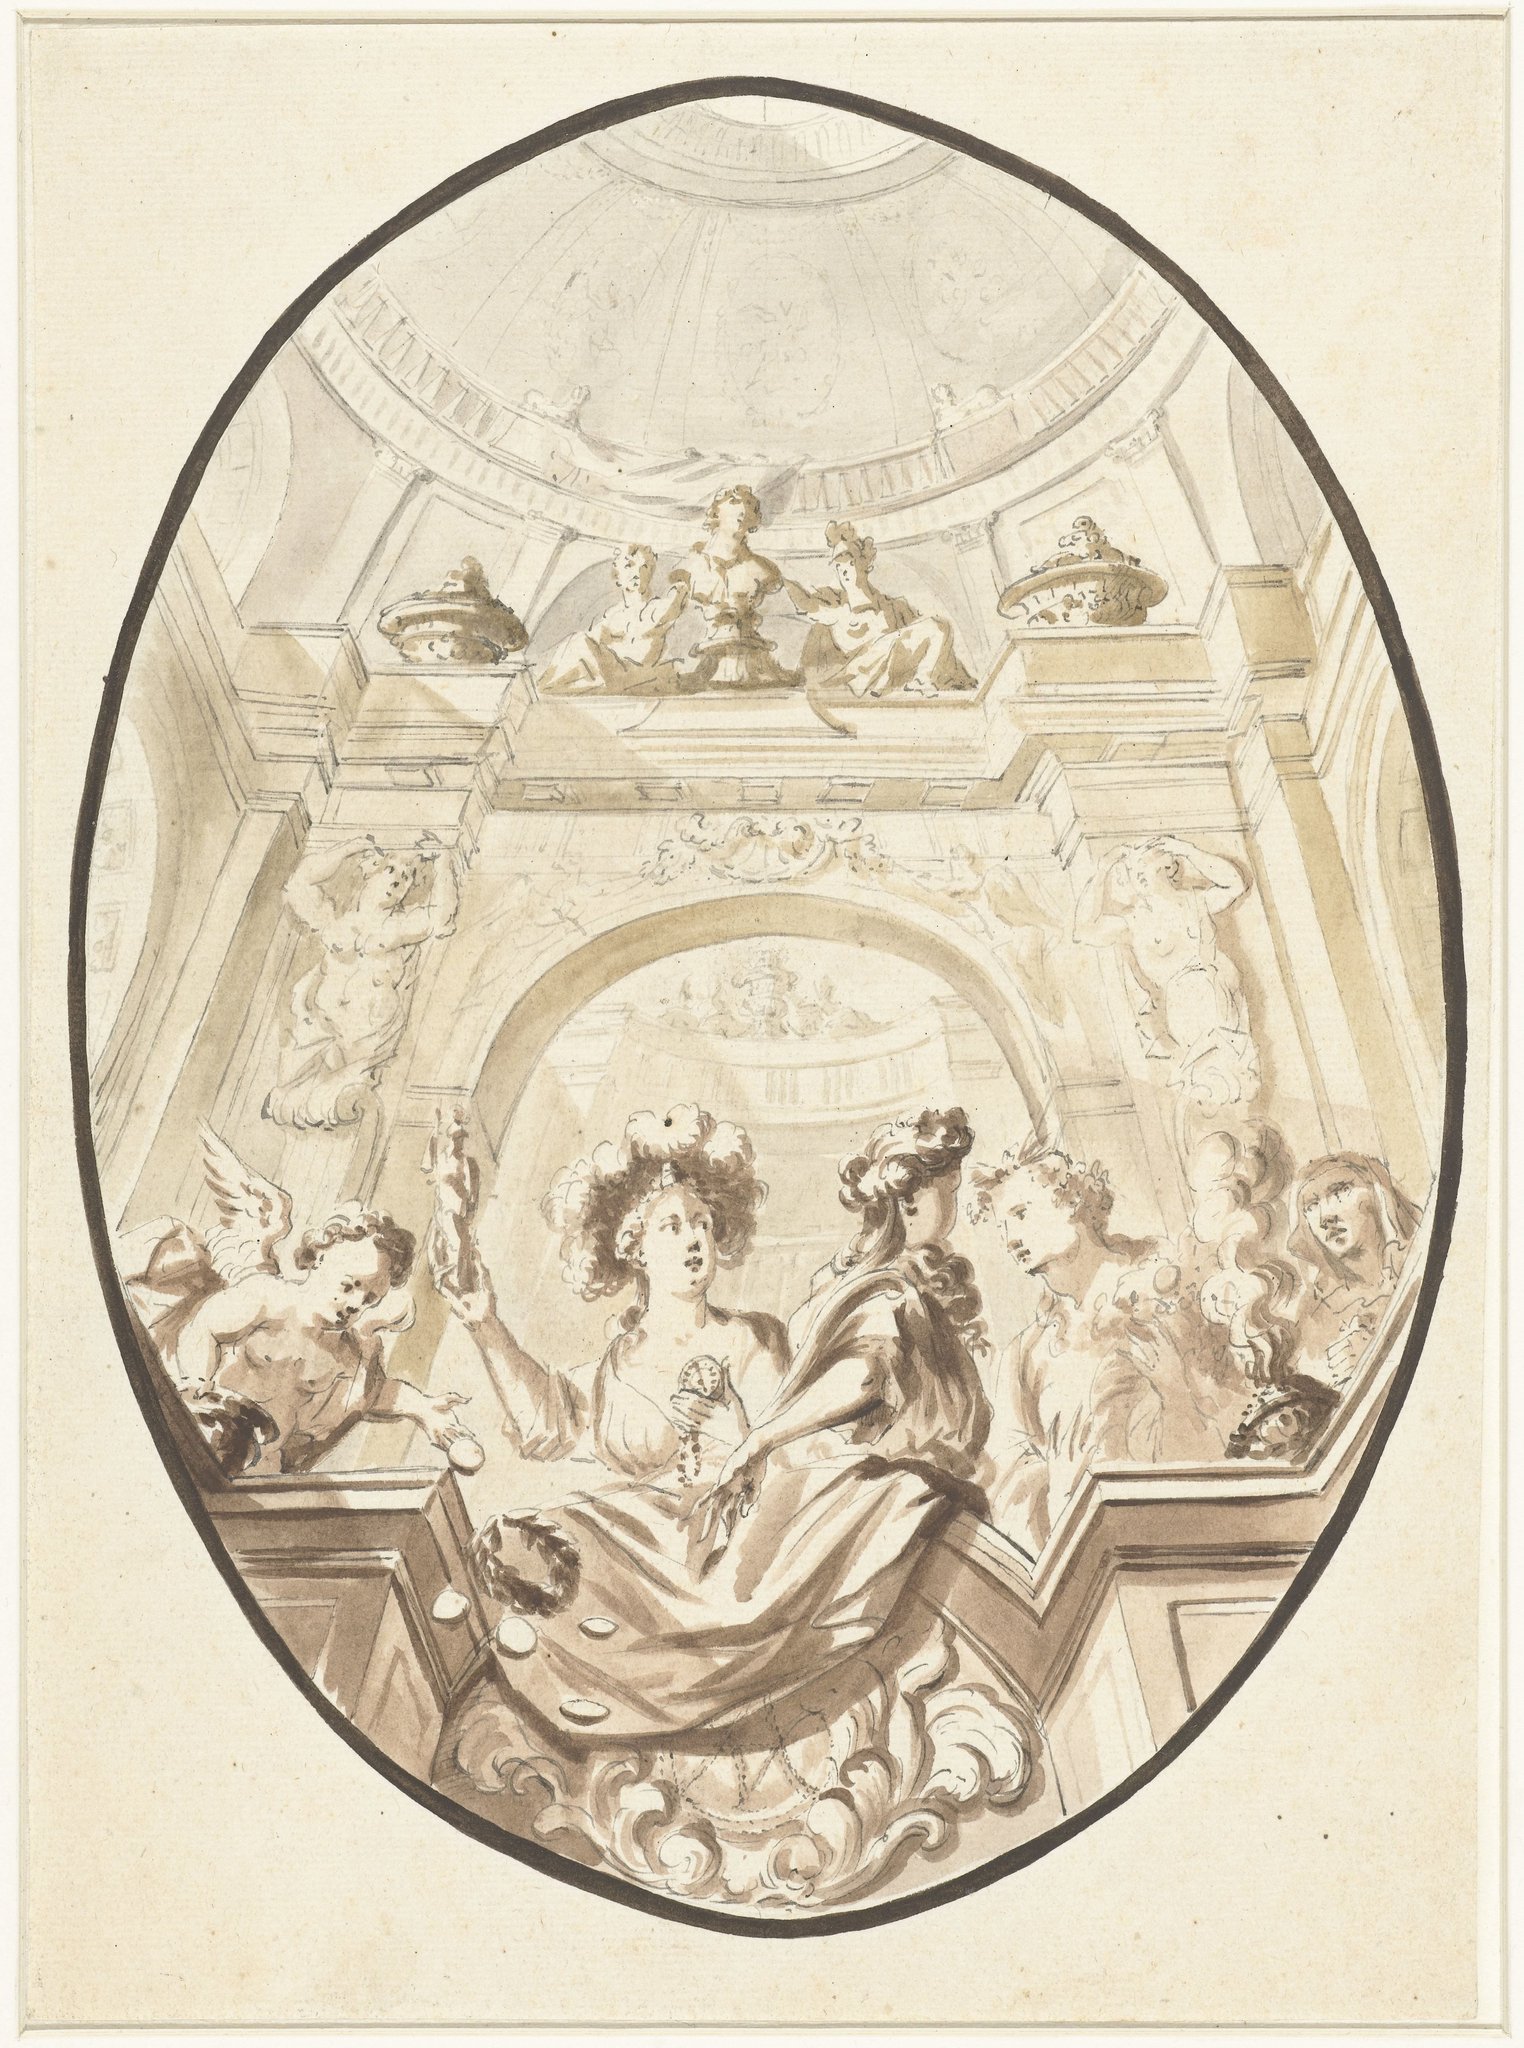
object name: design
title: Ontwerp voor een plafondschildering met allegorische figuren op een balustrade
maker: Anonymous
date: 1700-1800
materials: ink, paper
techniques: brush, pen